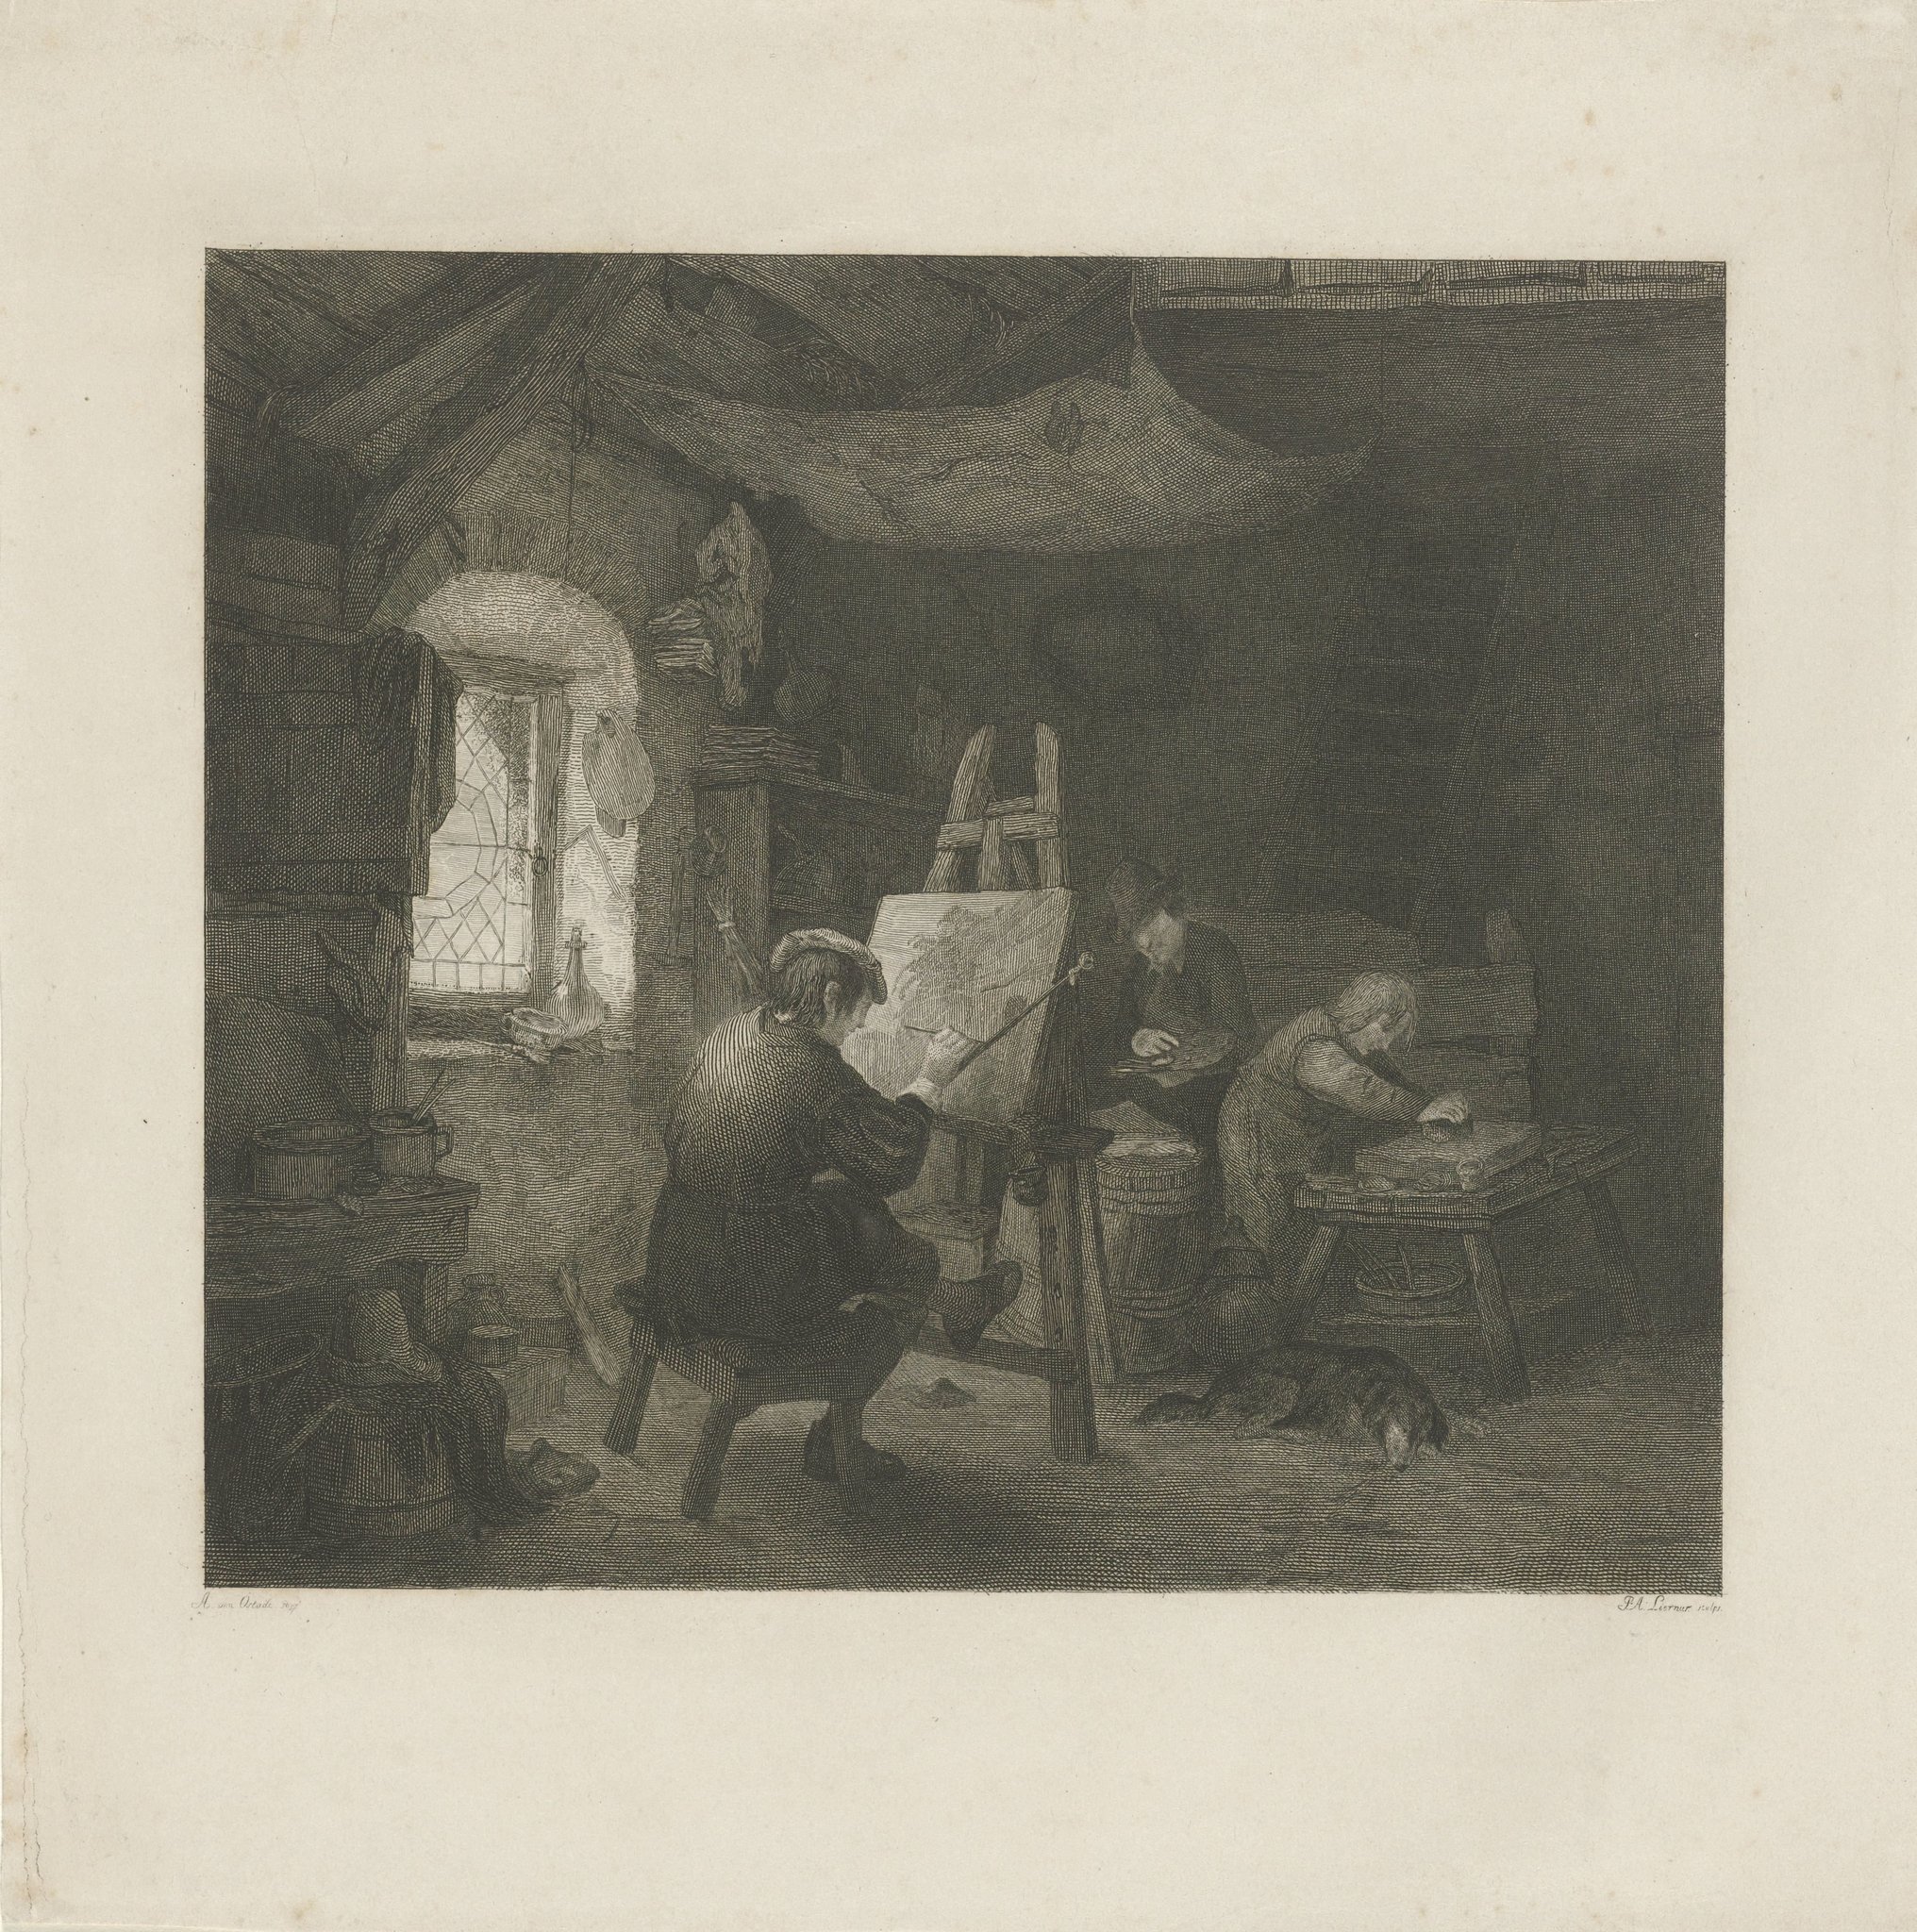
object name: print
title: Schilder in zijn atelier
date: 1841-1857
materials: paper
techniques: etching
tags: painter at work, in his studio, painter preparing colours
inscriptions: collector's mark: Lugt 2228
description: Een schilder aan het werk in zijn atelier. Hij zit achter een ezel bij het raam, hierachter bereiden twee assistenten of leerlingen verf.